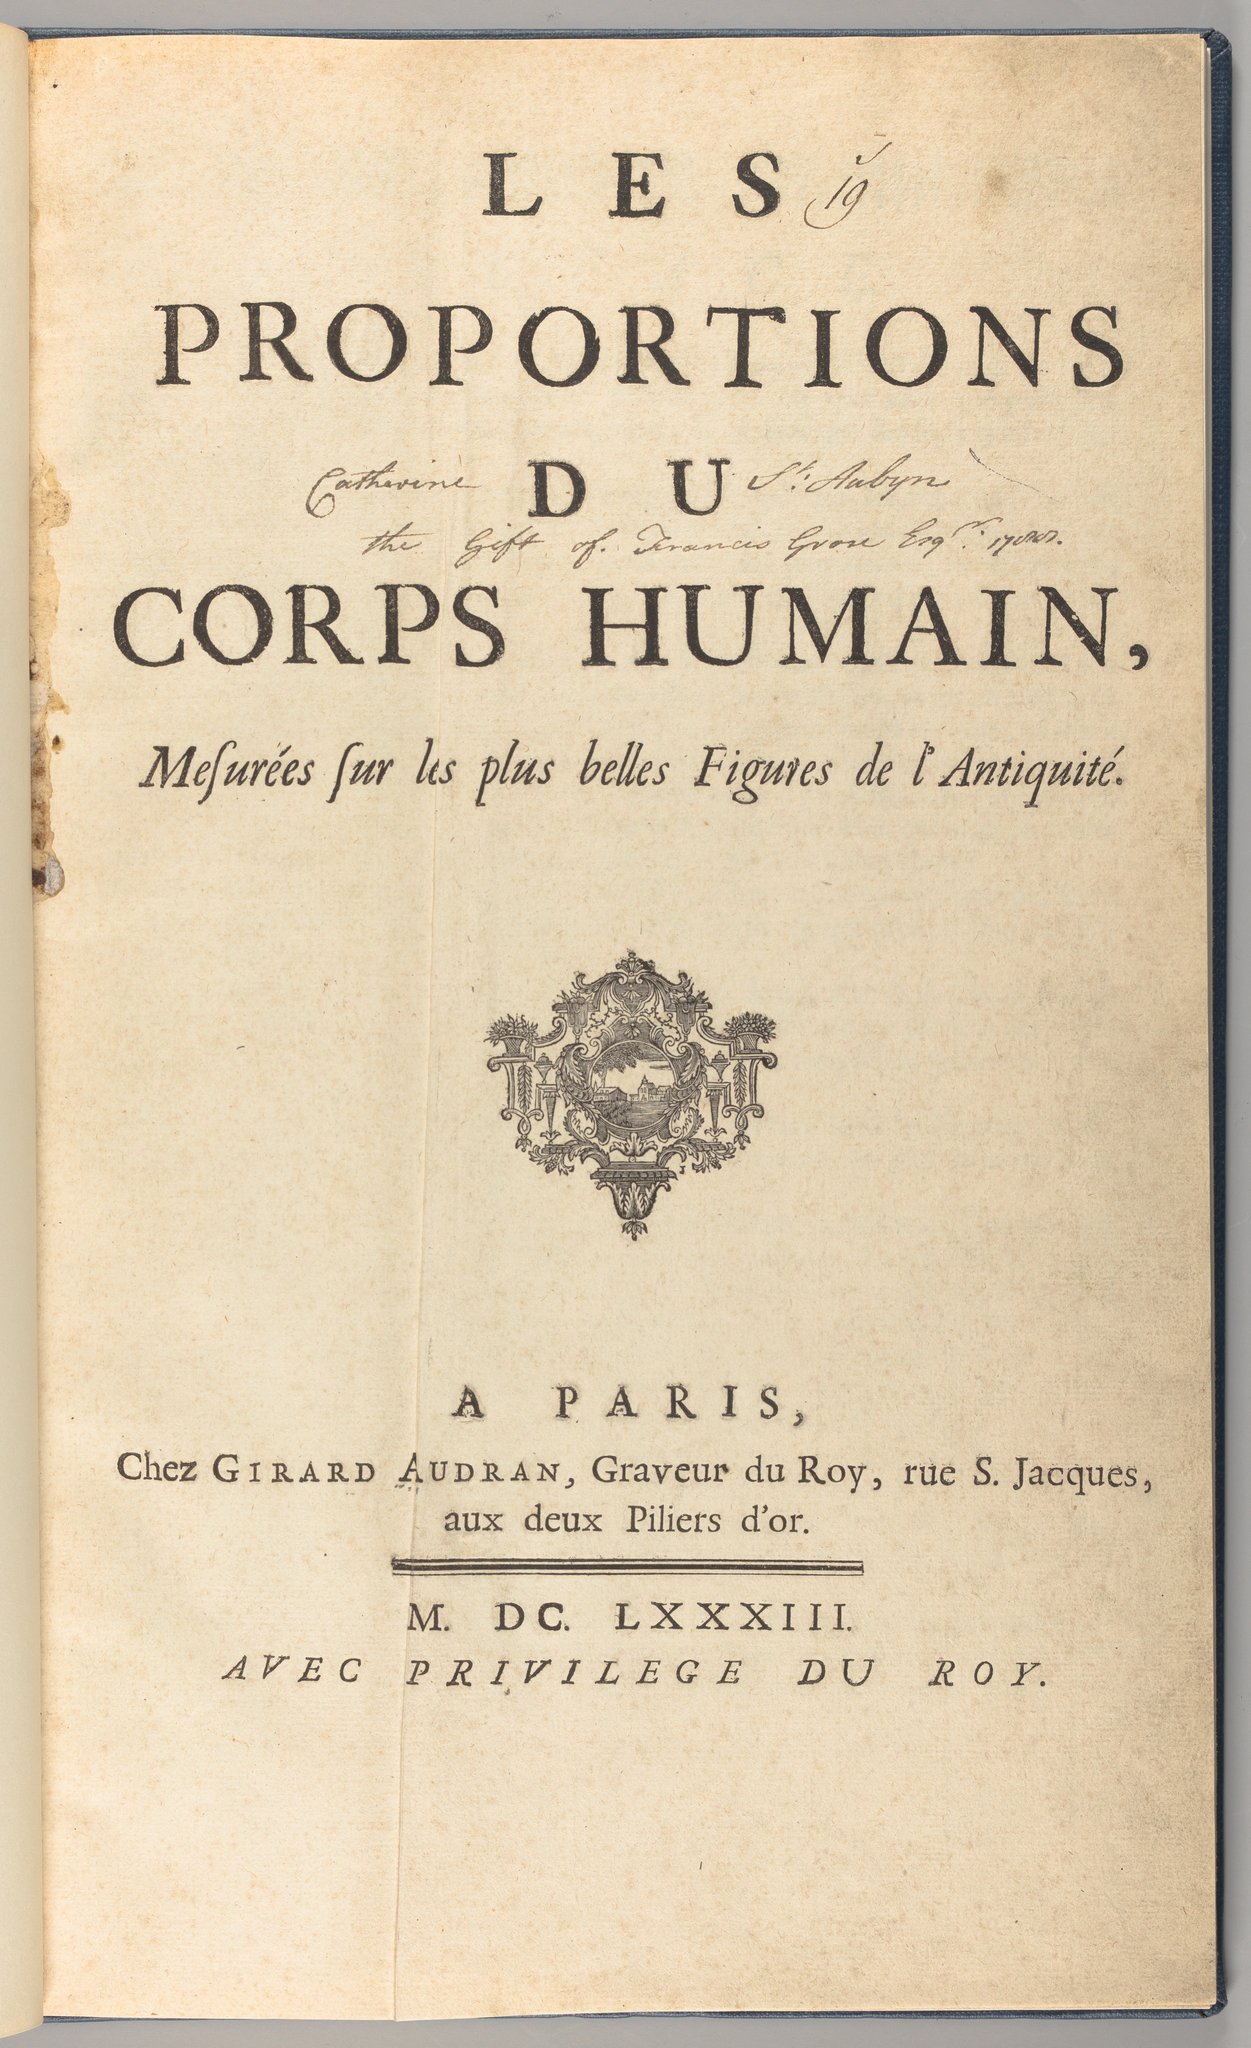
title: Les proportions du corps humain, mesurées sur les plus belles figures de l'antiquité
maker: girard audran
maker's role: printmaker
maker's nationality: french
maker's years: 1640-1703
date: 1683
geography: france